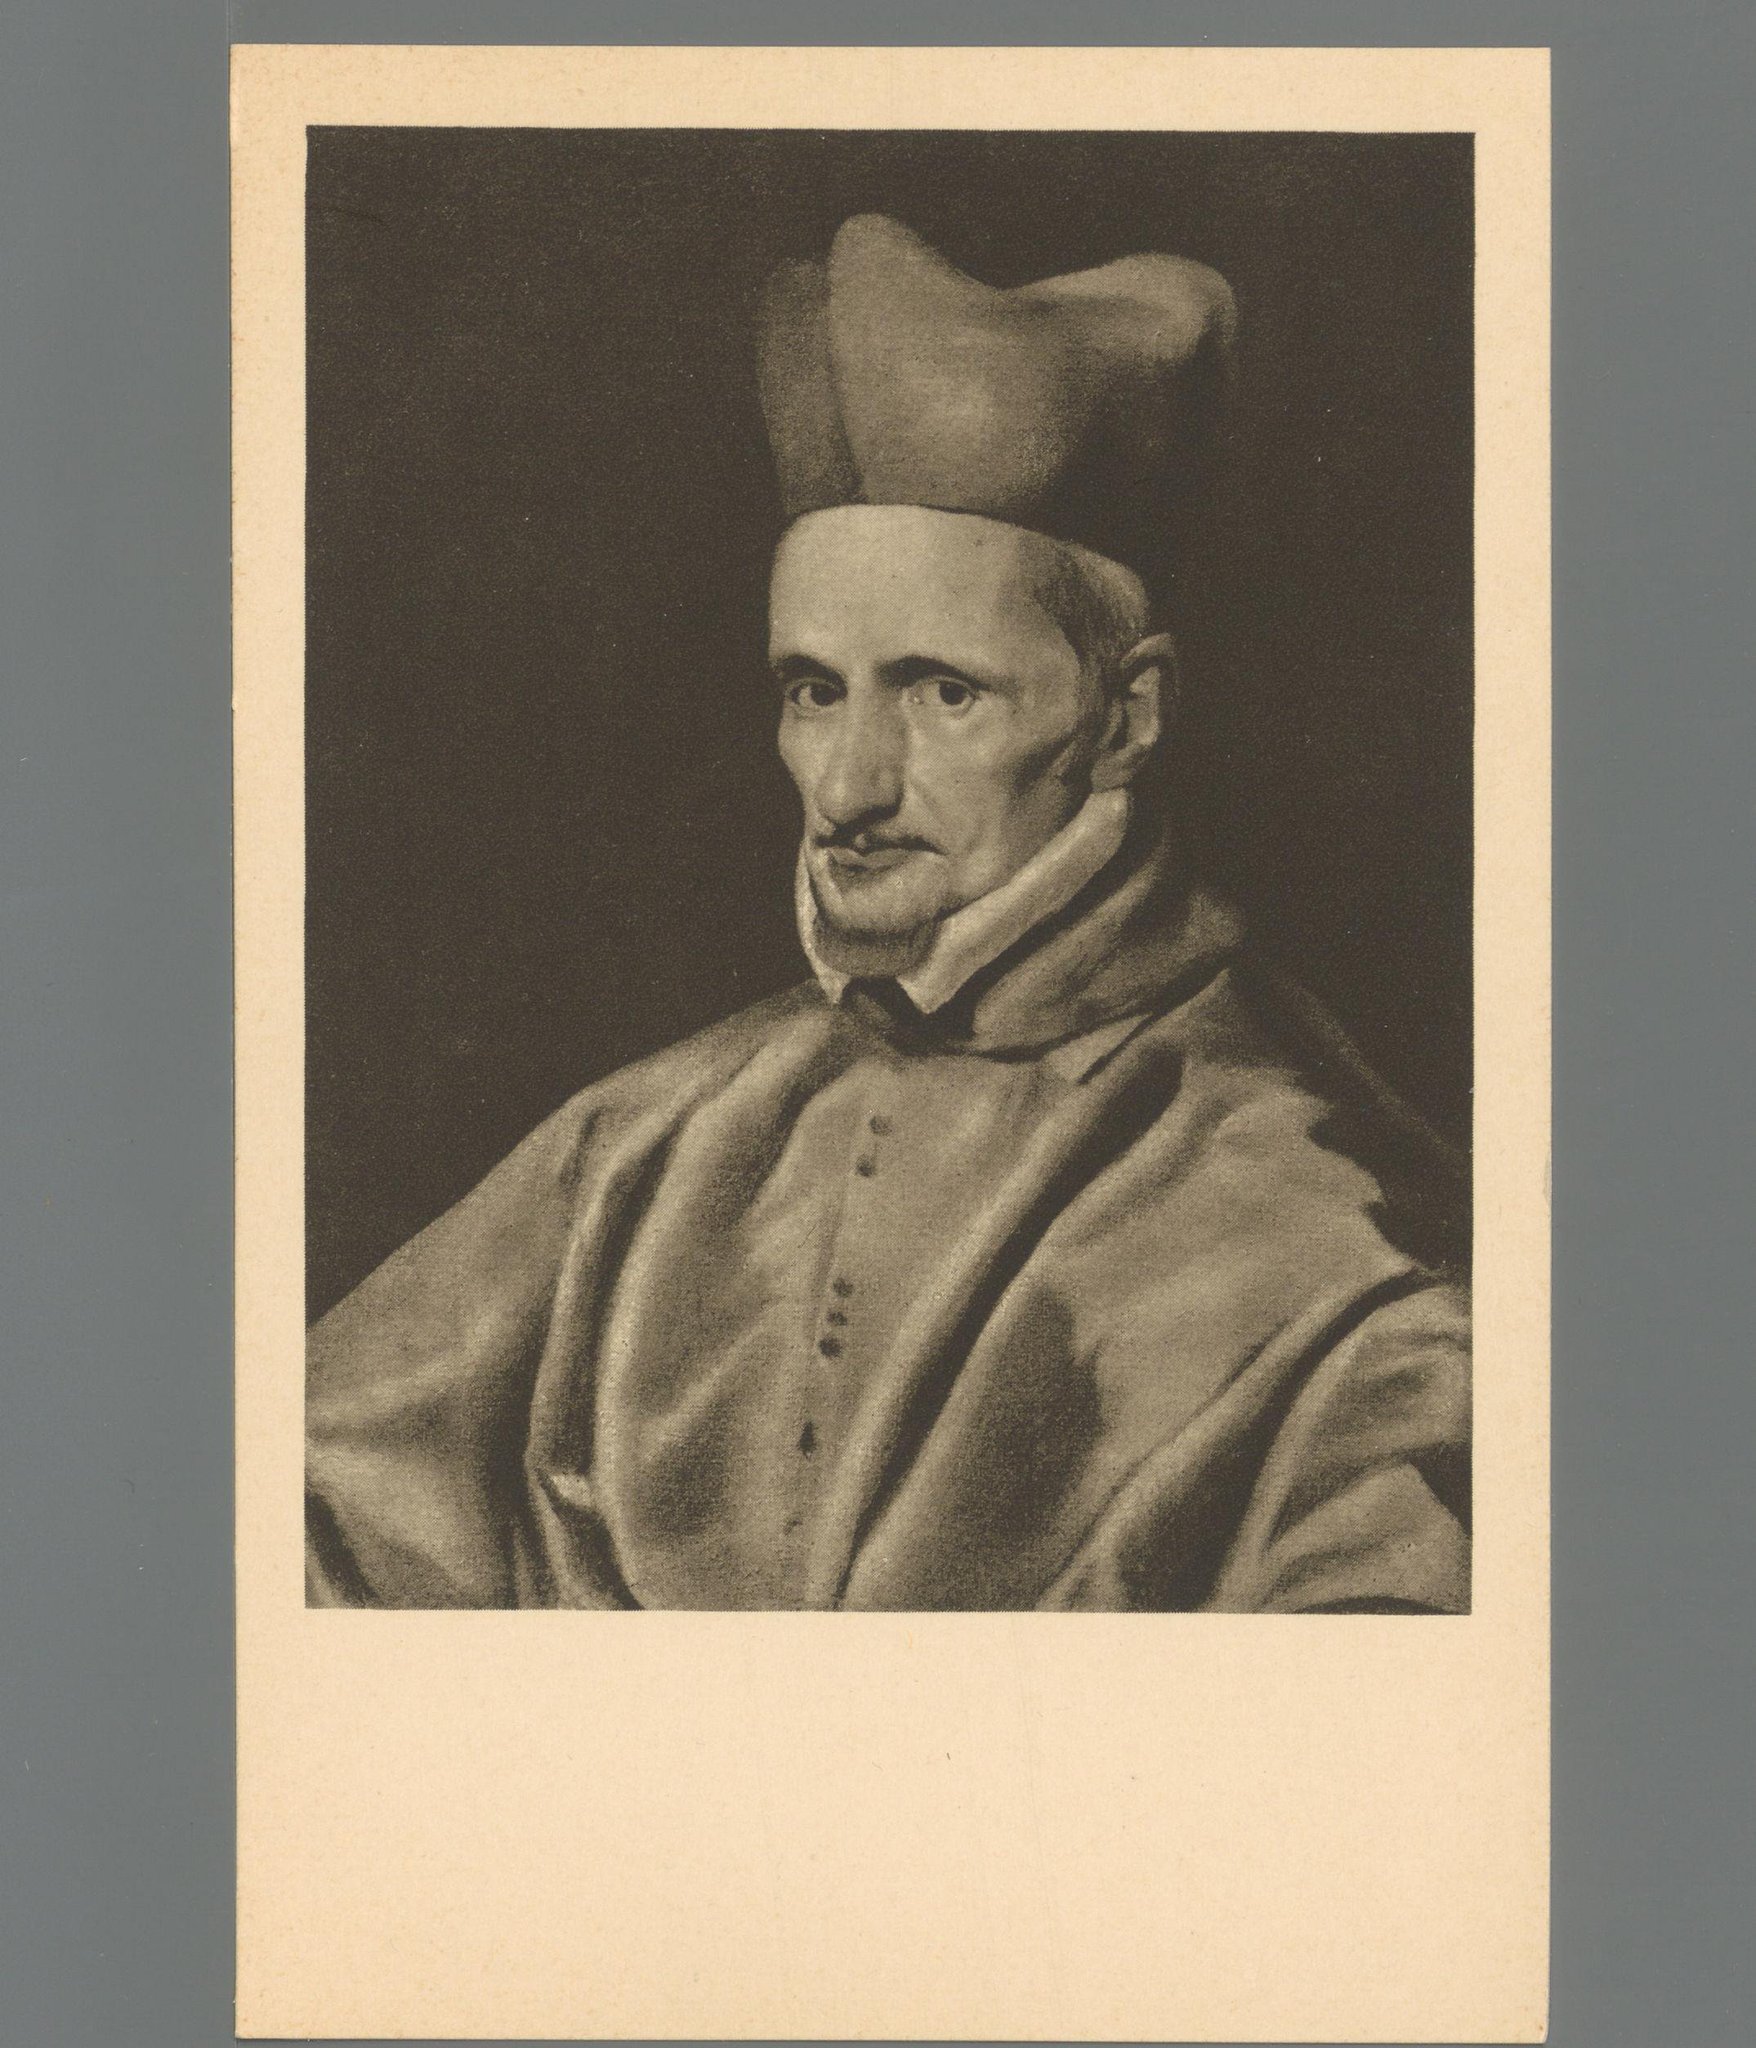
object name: reproduction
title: Velasquez. Kardinal Borja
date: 1905-1930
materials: cardboard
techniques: rotogravure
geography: frankfurt am main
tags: permanent exhibition, museum, picture, painting, historical persons (portraits and scenes from the life)